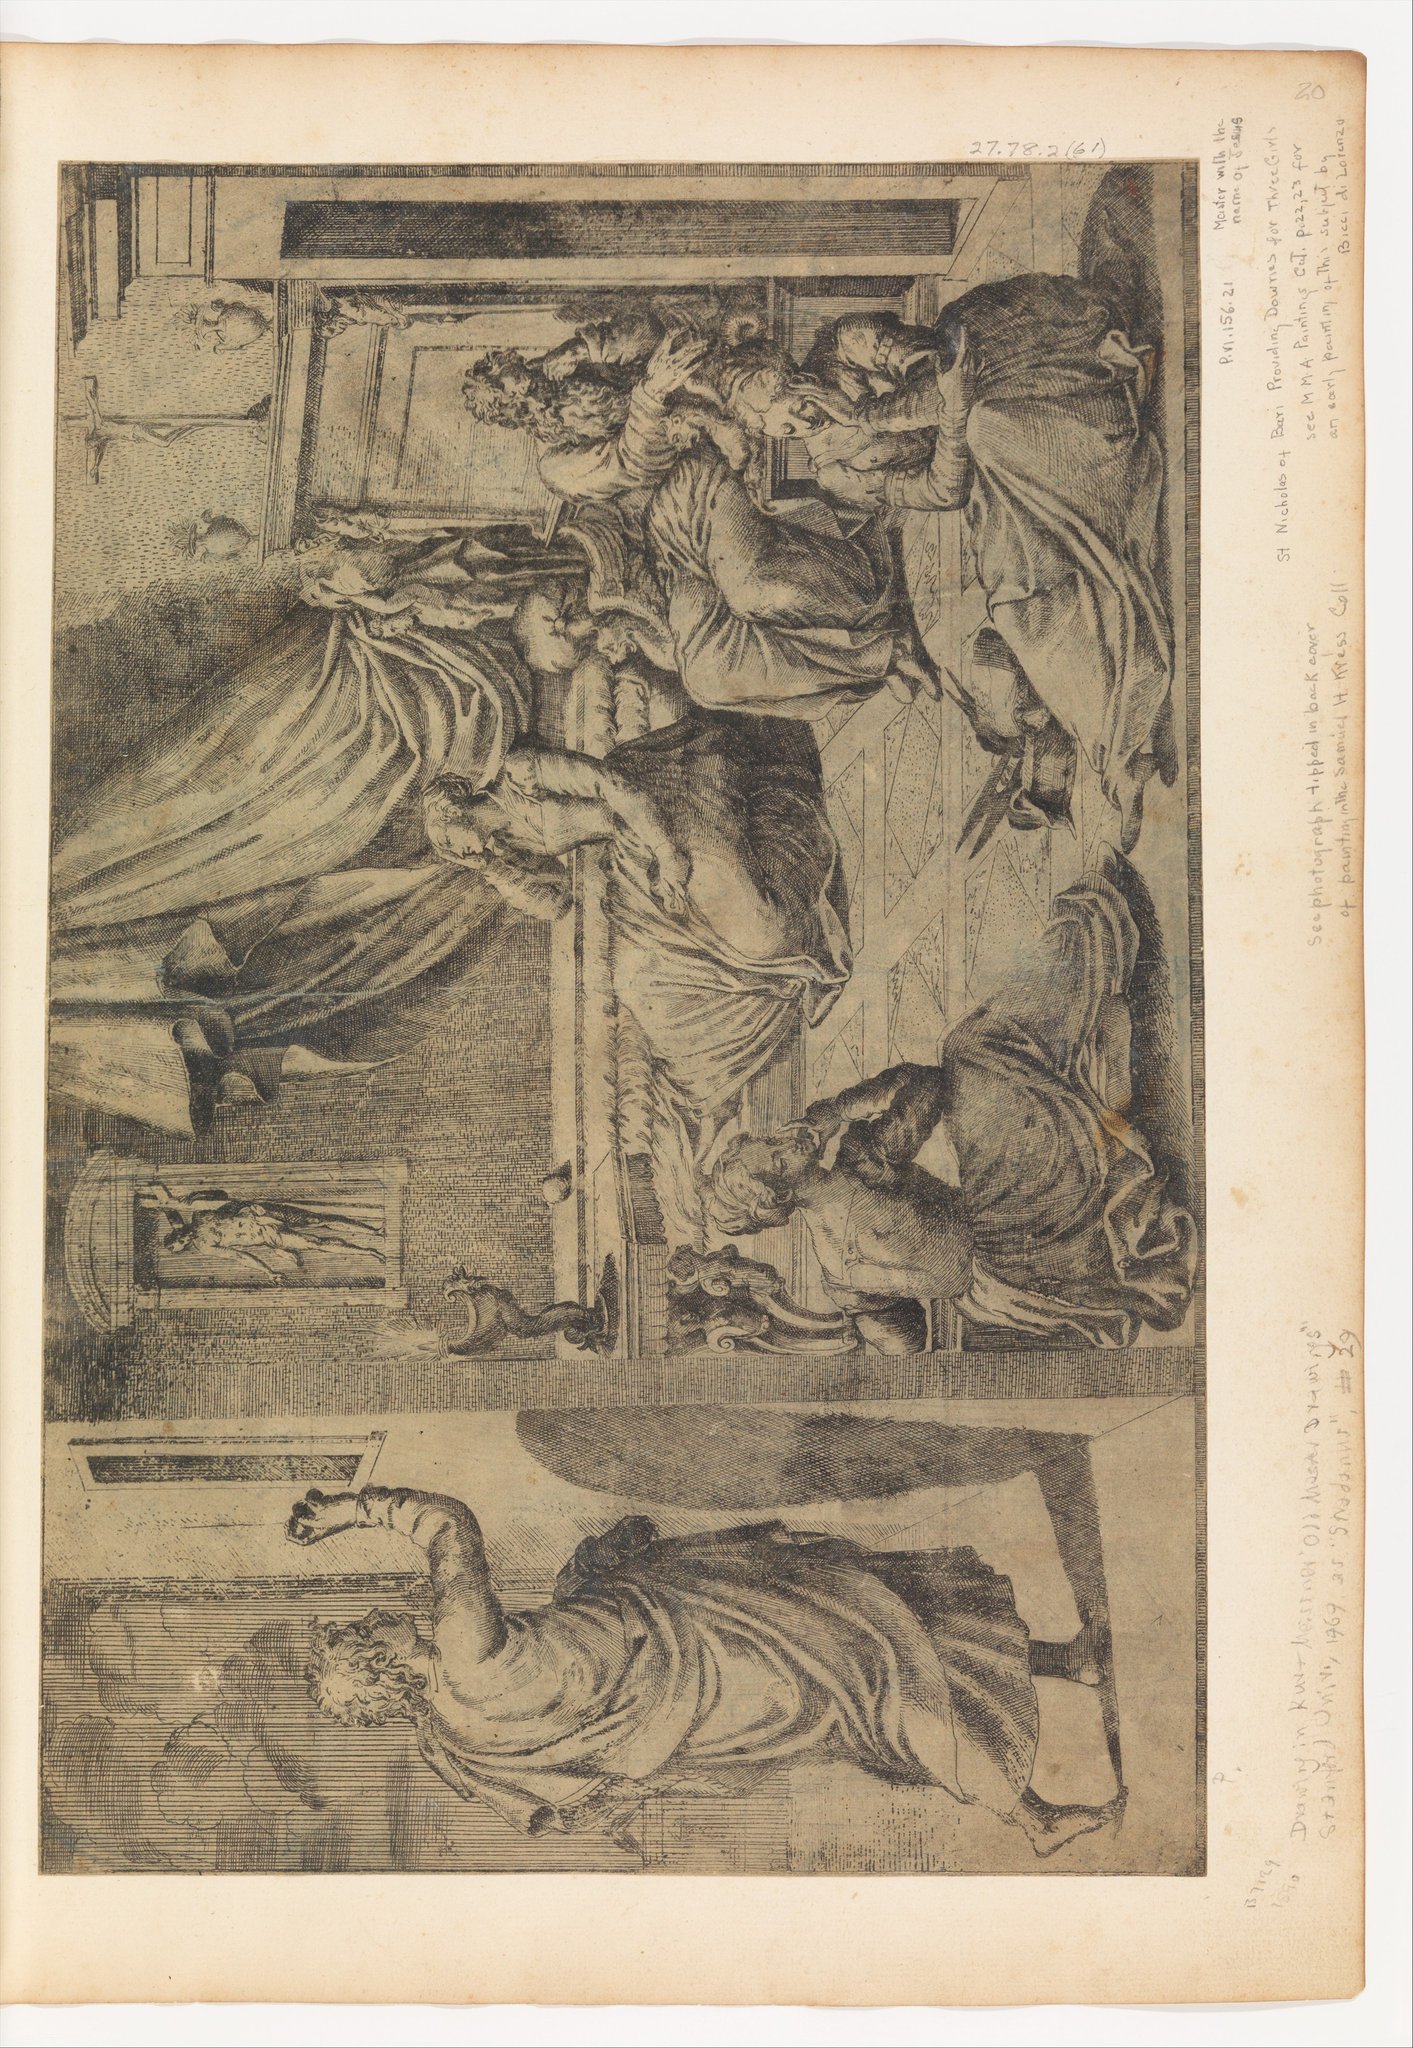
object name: print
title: St. Nicholas of Bari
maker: master with the name of jesus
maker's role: artist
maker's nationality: italian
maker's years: 16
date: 1501-1600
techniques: engraving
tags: men,women,saints